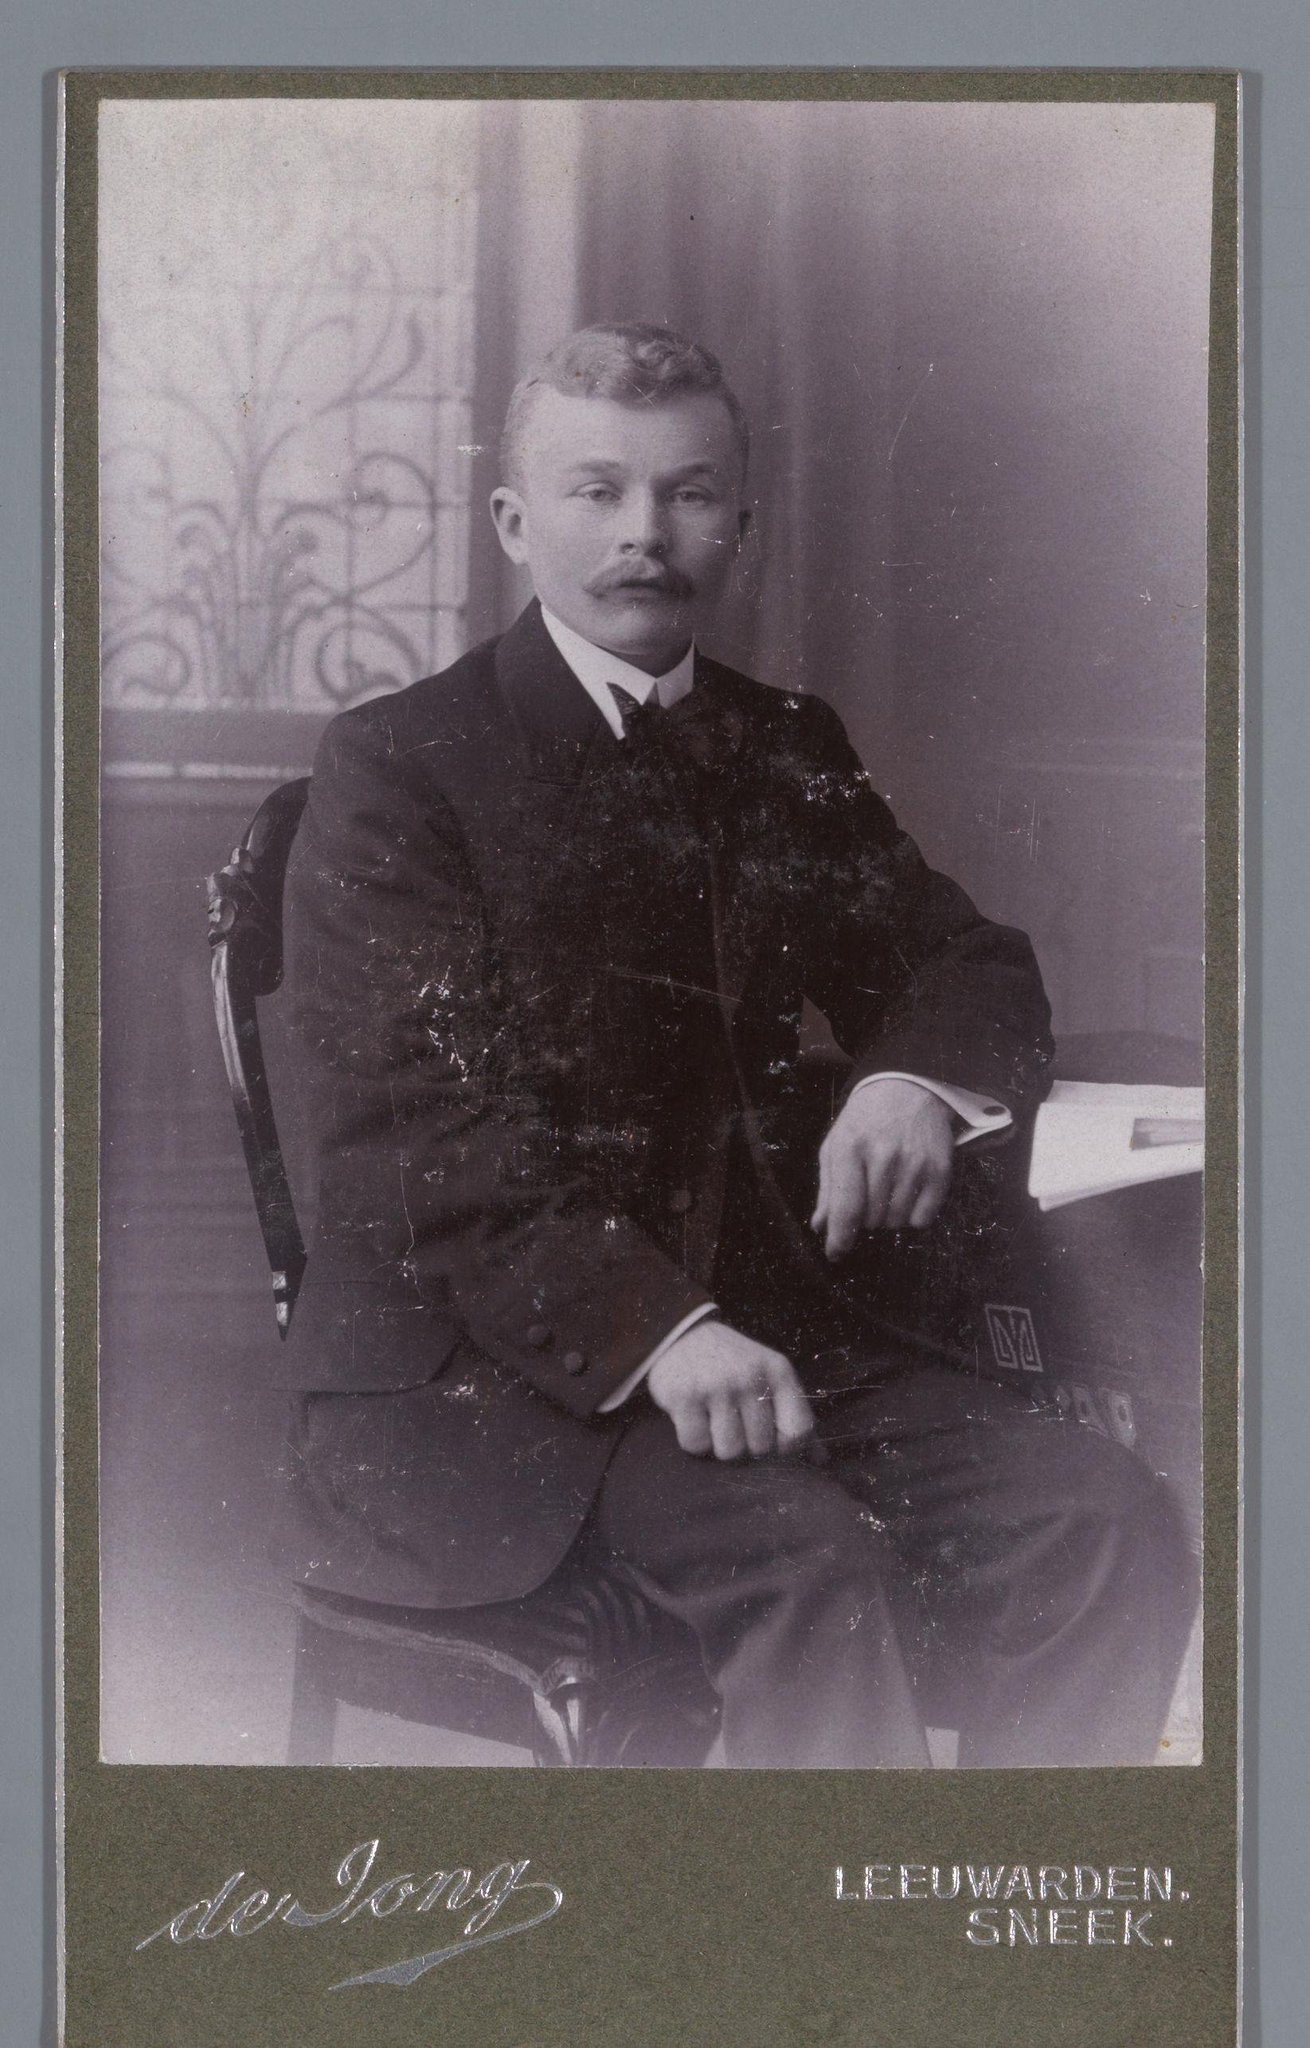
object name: photograph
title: Portret van een onbekende man met een snor, zittend aan een tafel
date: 1909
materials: cardboard, paper, photographic support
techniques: collodion silver print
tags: adult man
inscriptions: inscription: ‘1909 Fotogr. Atelier De Jong Leeuwarden Nieuwestad 53. Sneek Kl: zand. vergrootingen naar elk portret. De plaat blijft voor nabestelling bewaard.’, name: ‘de Jong Leeuwarden. Sneek.’, name: ‘Prager & Lojda, Berlin.’